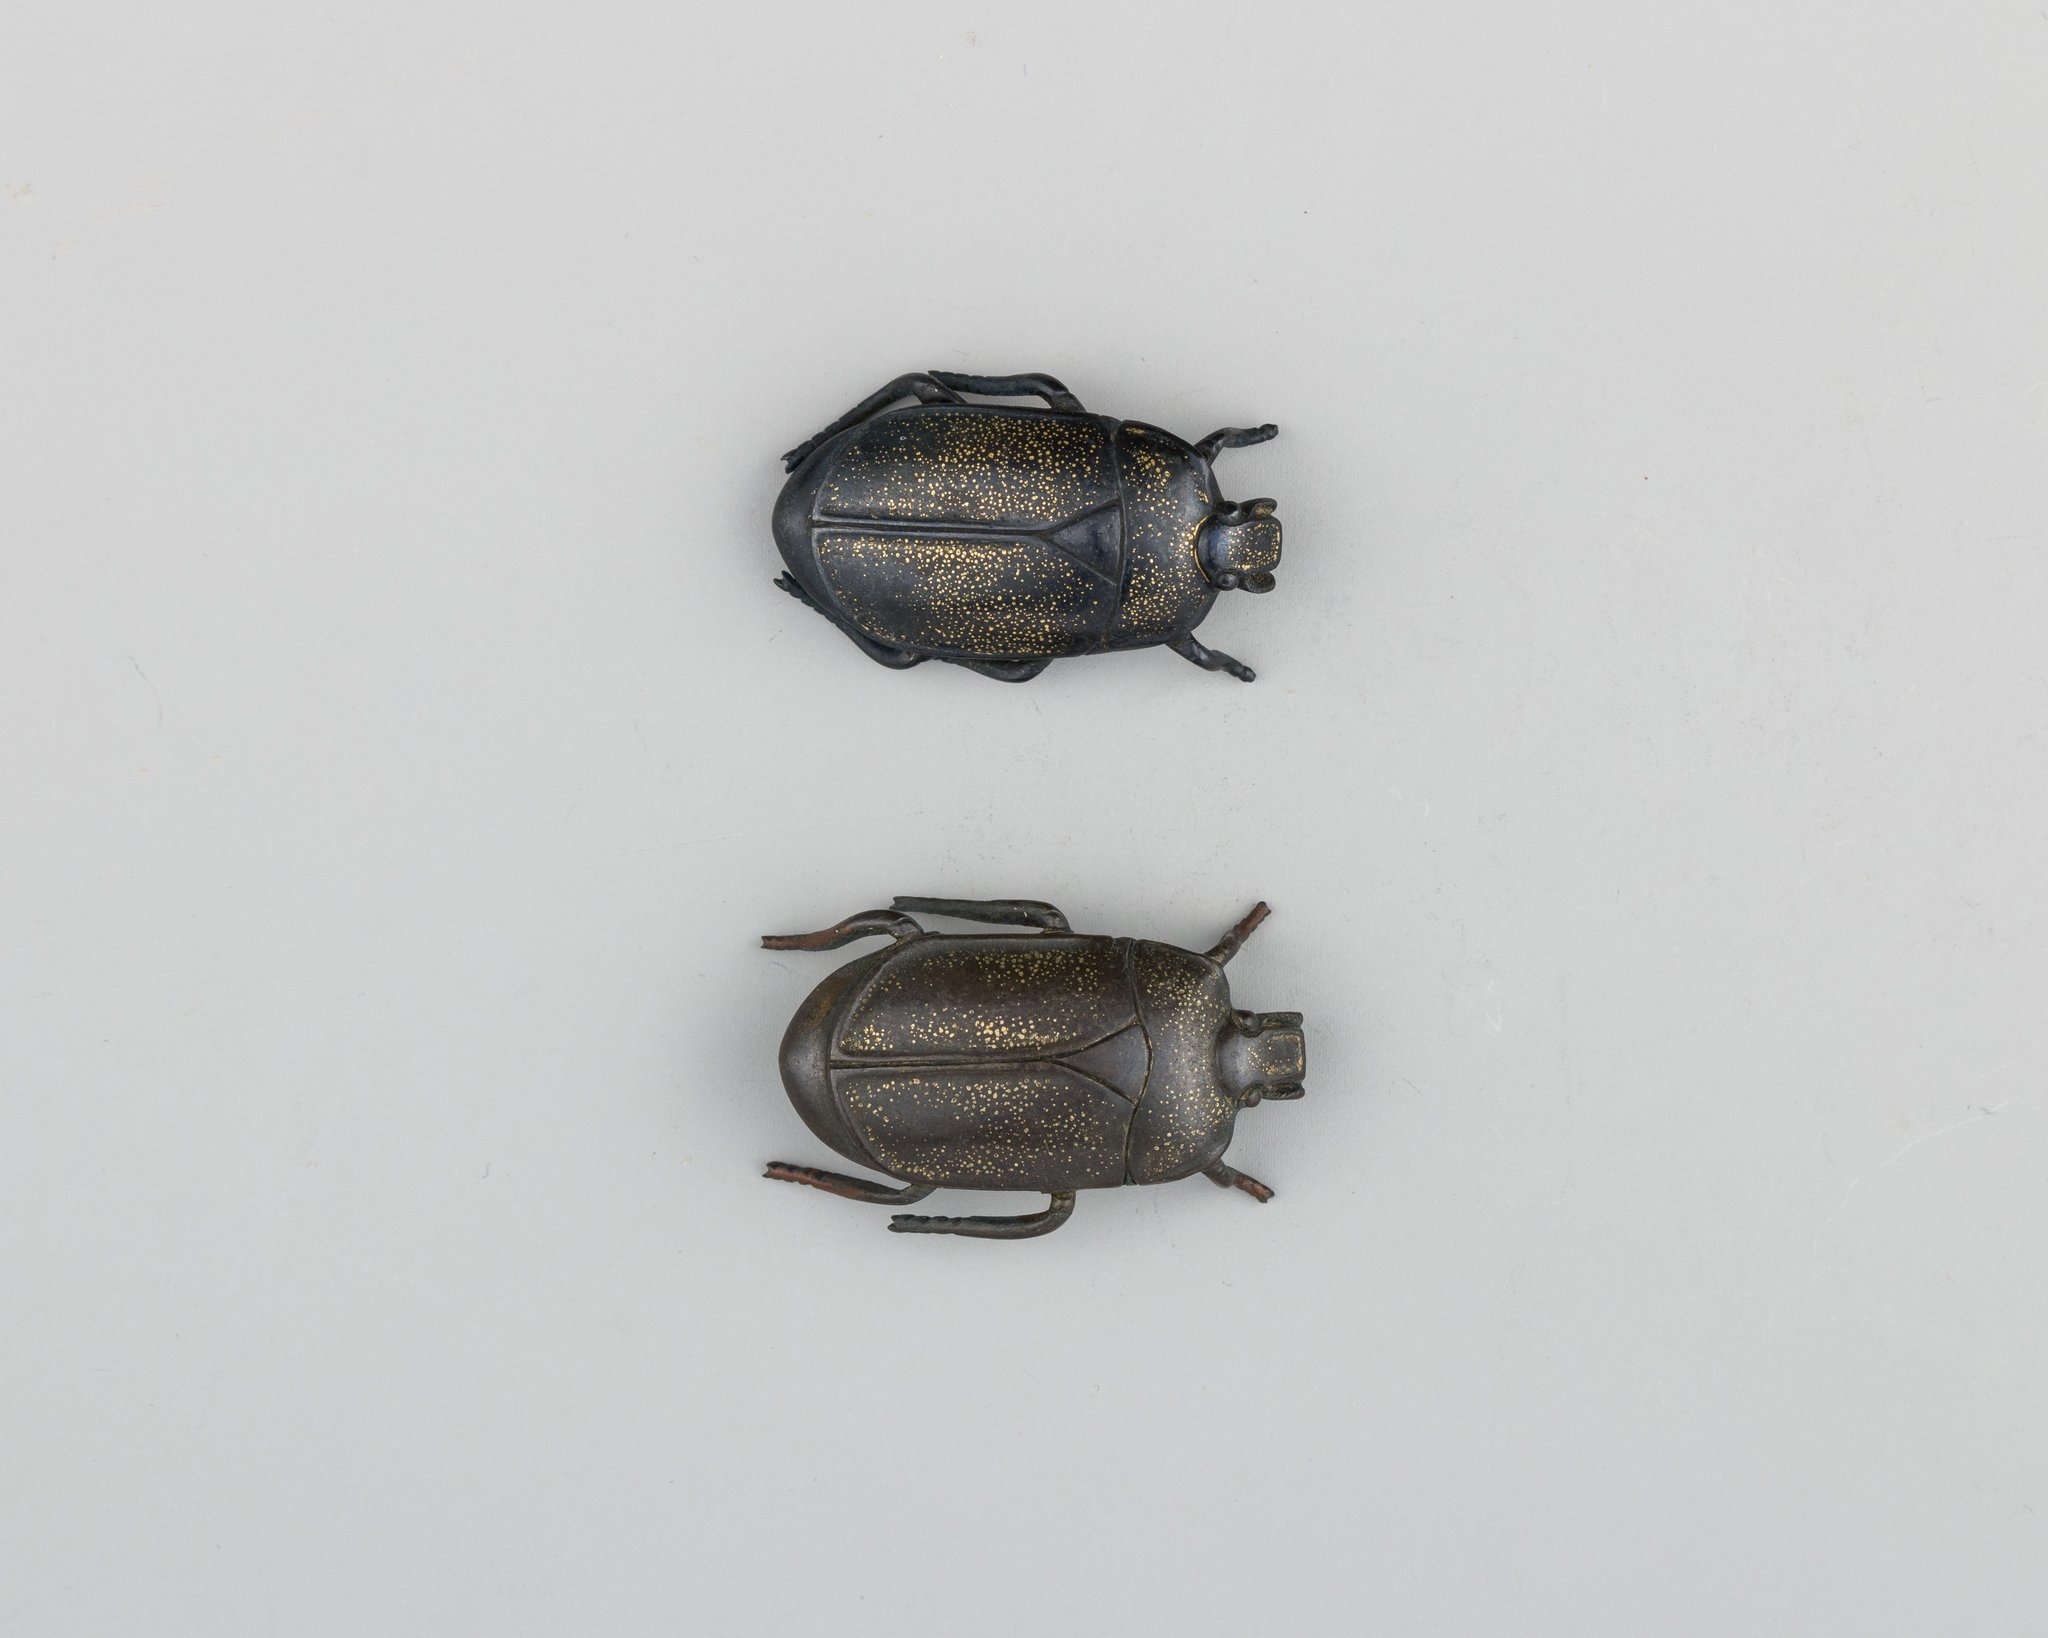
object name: pair of sword grip ornament menuki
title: Pair of Sword-Grip Ornaments (Menuki)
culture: japanese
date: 1801-1900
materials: gold alloy, silver alloy, gold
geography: japan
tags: insects